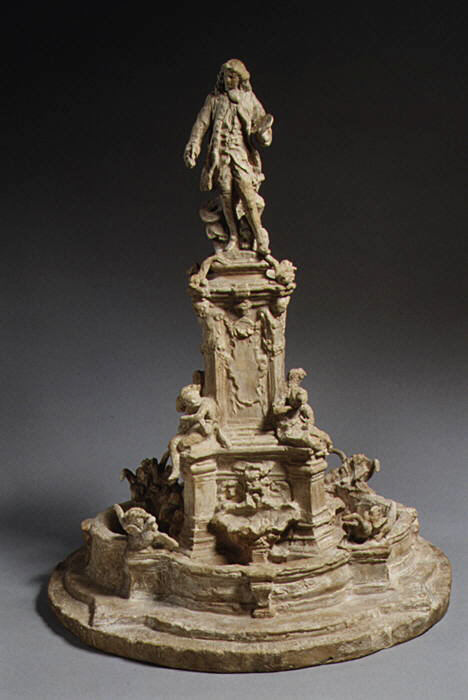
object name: fountain model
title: Model for the Watteau Fountain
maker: jean-baptiste carpeaux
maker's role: artist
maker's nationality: french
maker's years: 1827-1875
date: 1867-1868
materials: plaster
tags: men